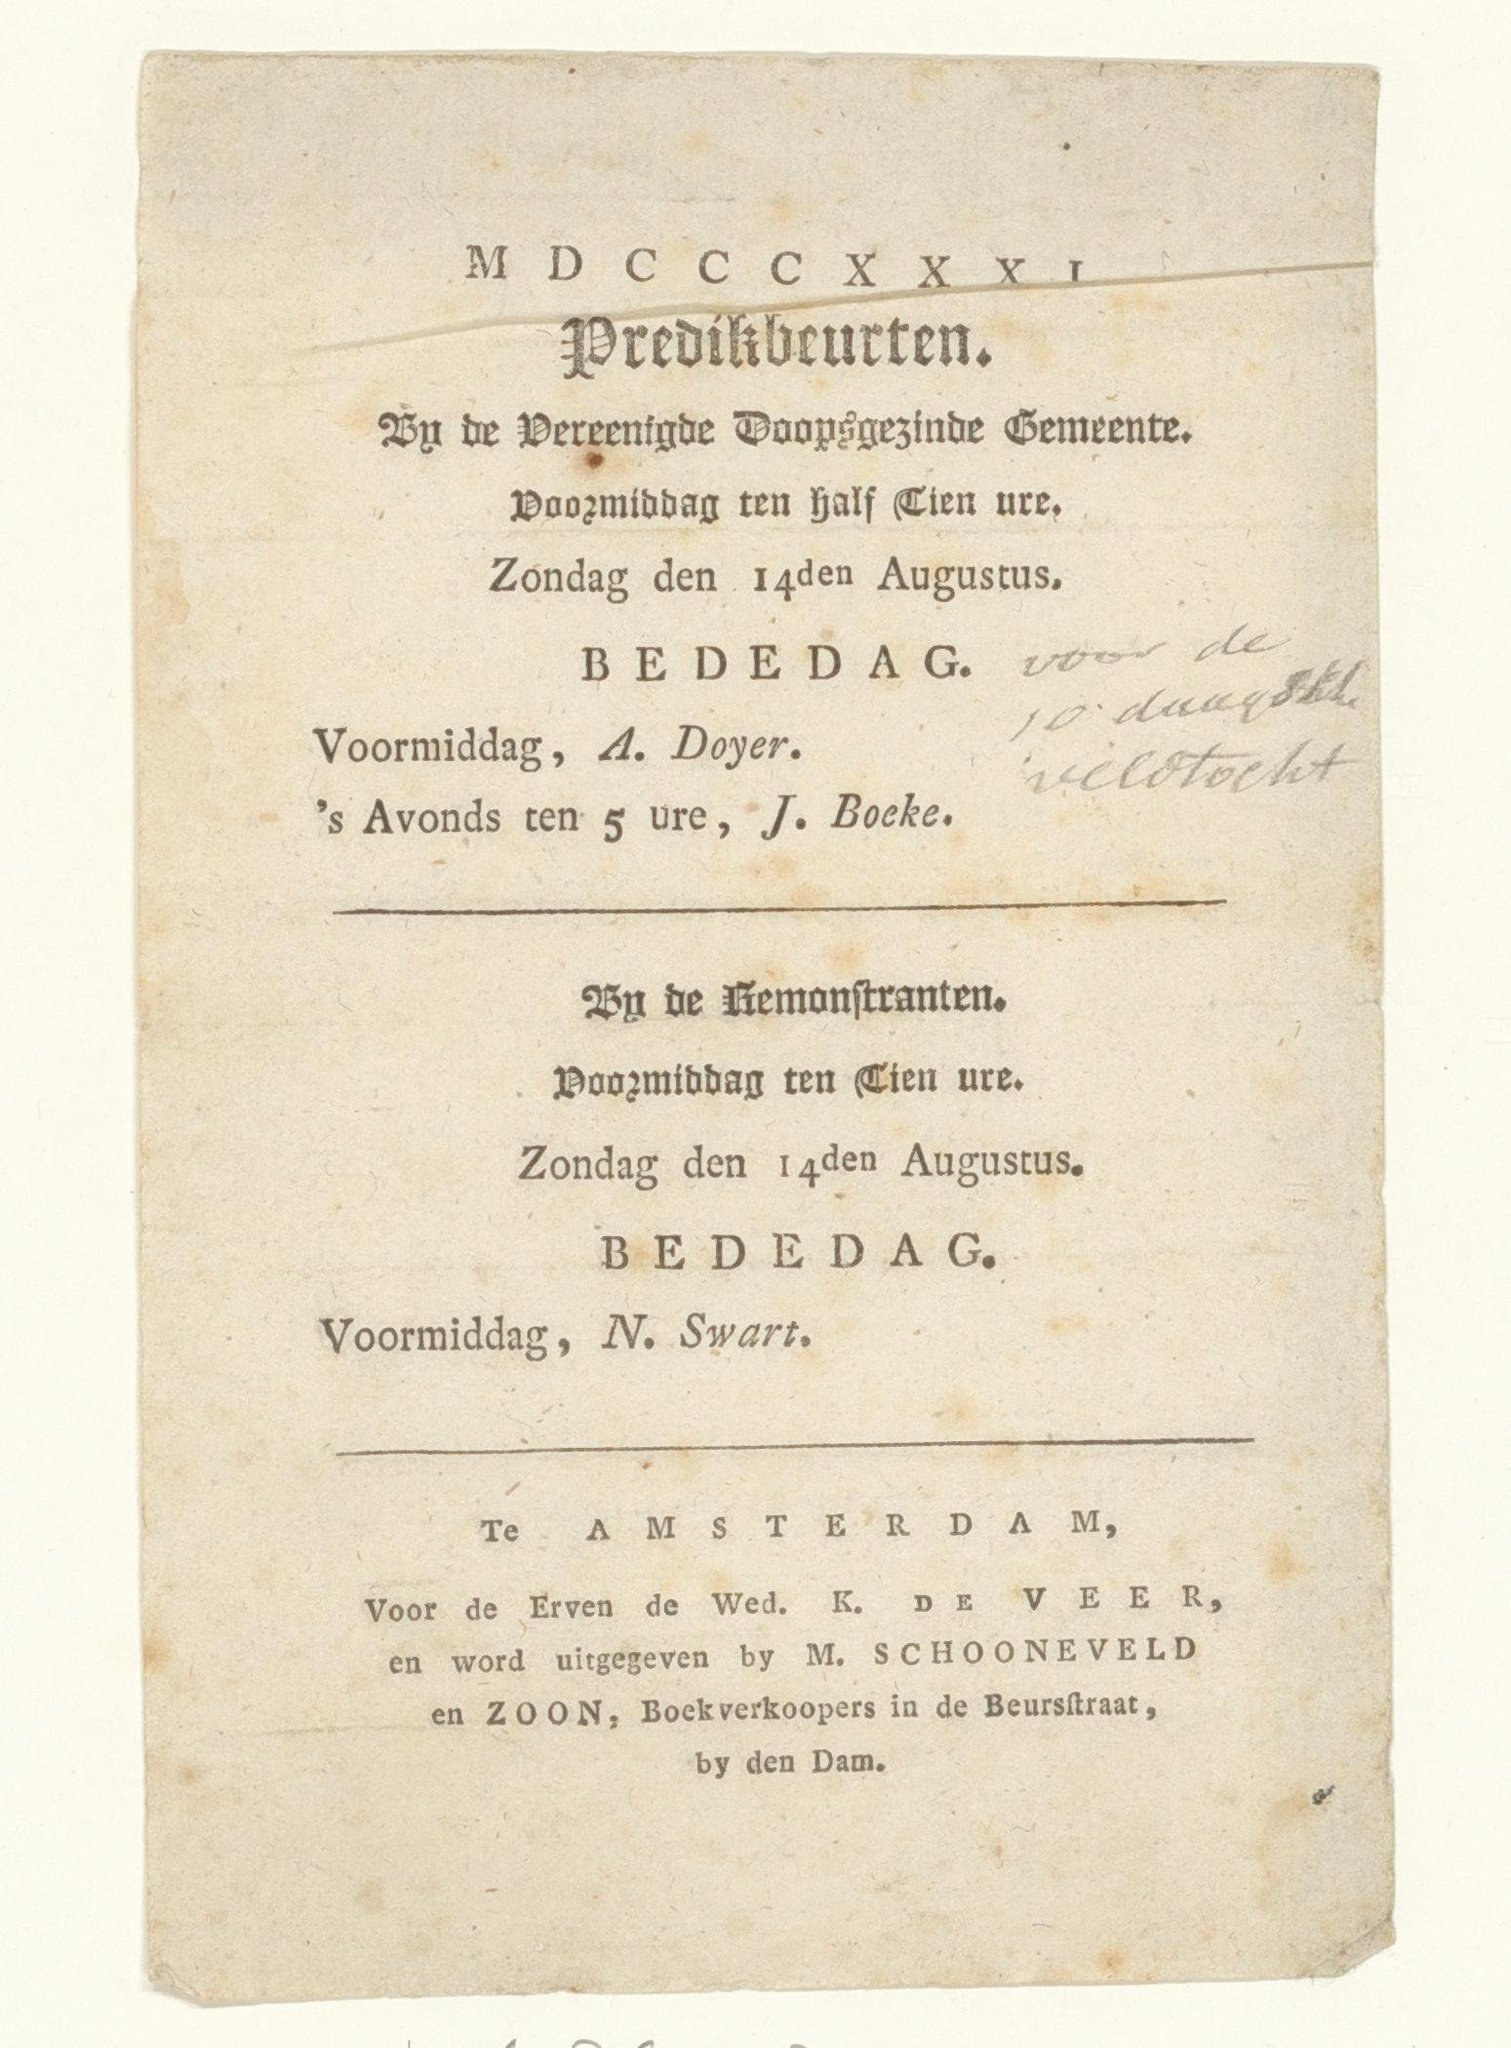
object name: text sheet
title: Preken van de Vereenigde Doopsgezinde Gemeente op 14 augustus 1831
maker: Anonymous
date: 1831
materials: paper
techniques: letterpress printing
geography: amsterdam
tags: preaching (in general)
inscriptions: stamp, collector's mark: Lugt 1641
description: Preken van de Vereenigde Doopsgezinde Gemeente op 14 augustus 1831 in Amsterdam. Bij de preken staan de namen van de predikanten. Onderwerpsrubrieken binnen de Atlas Zeden en Gewoonten: Godsdienst, Predikbeurtenlijstjes.